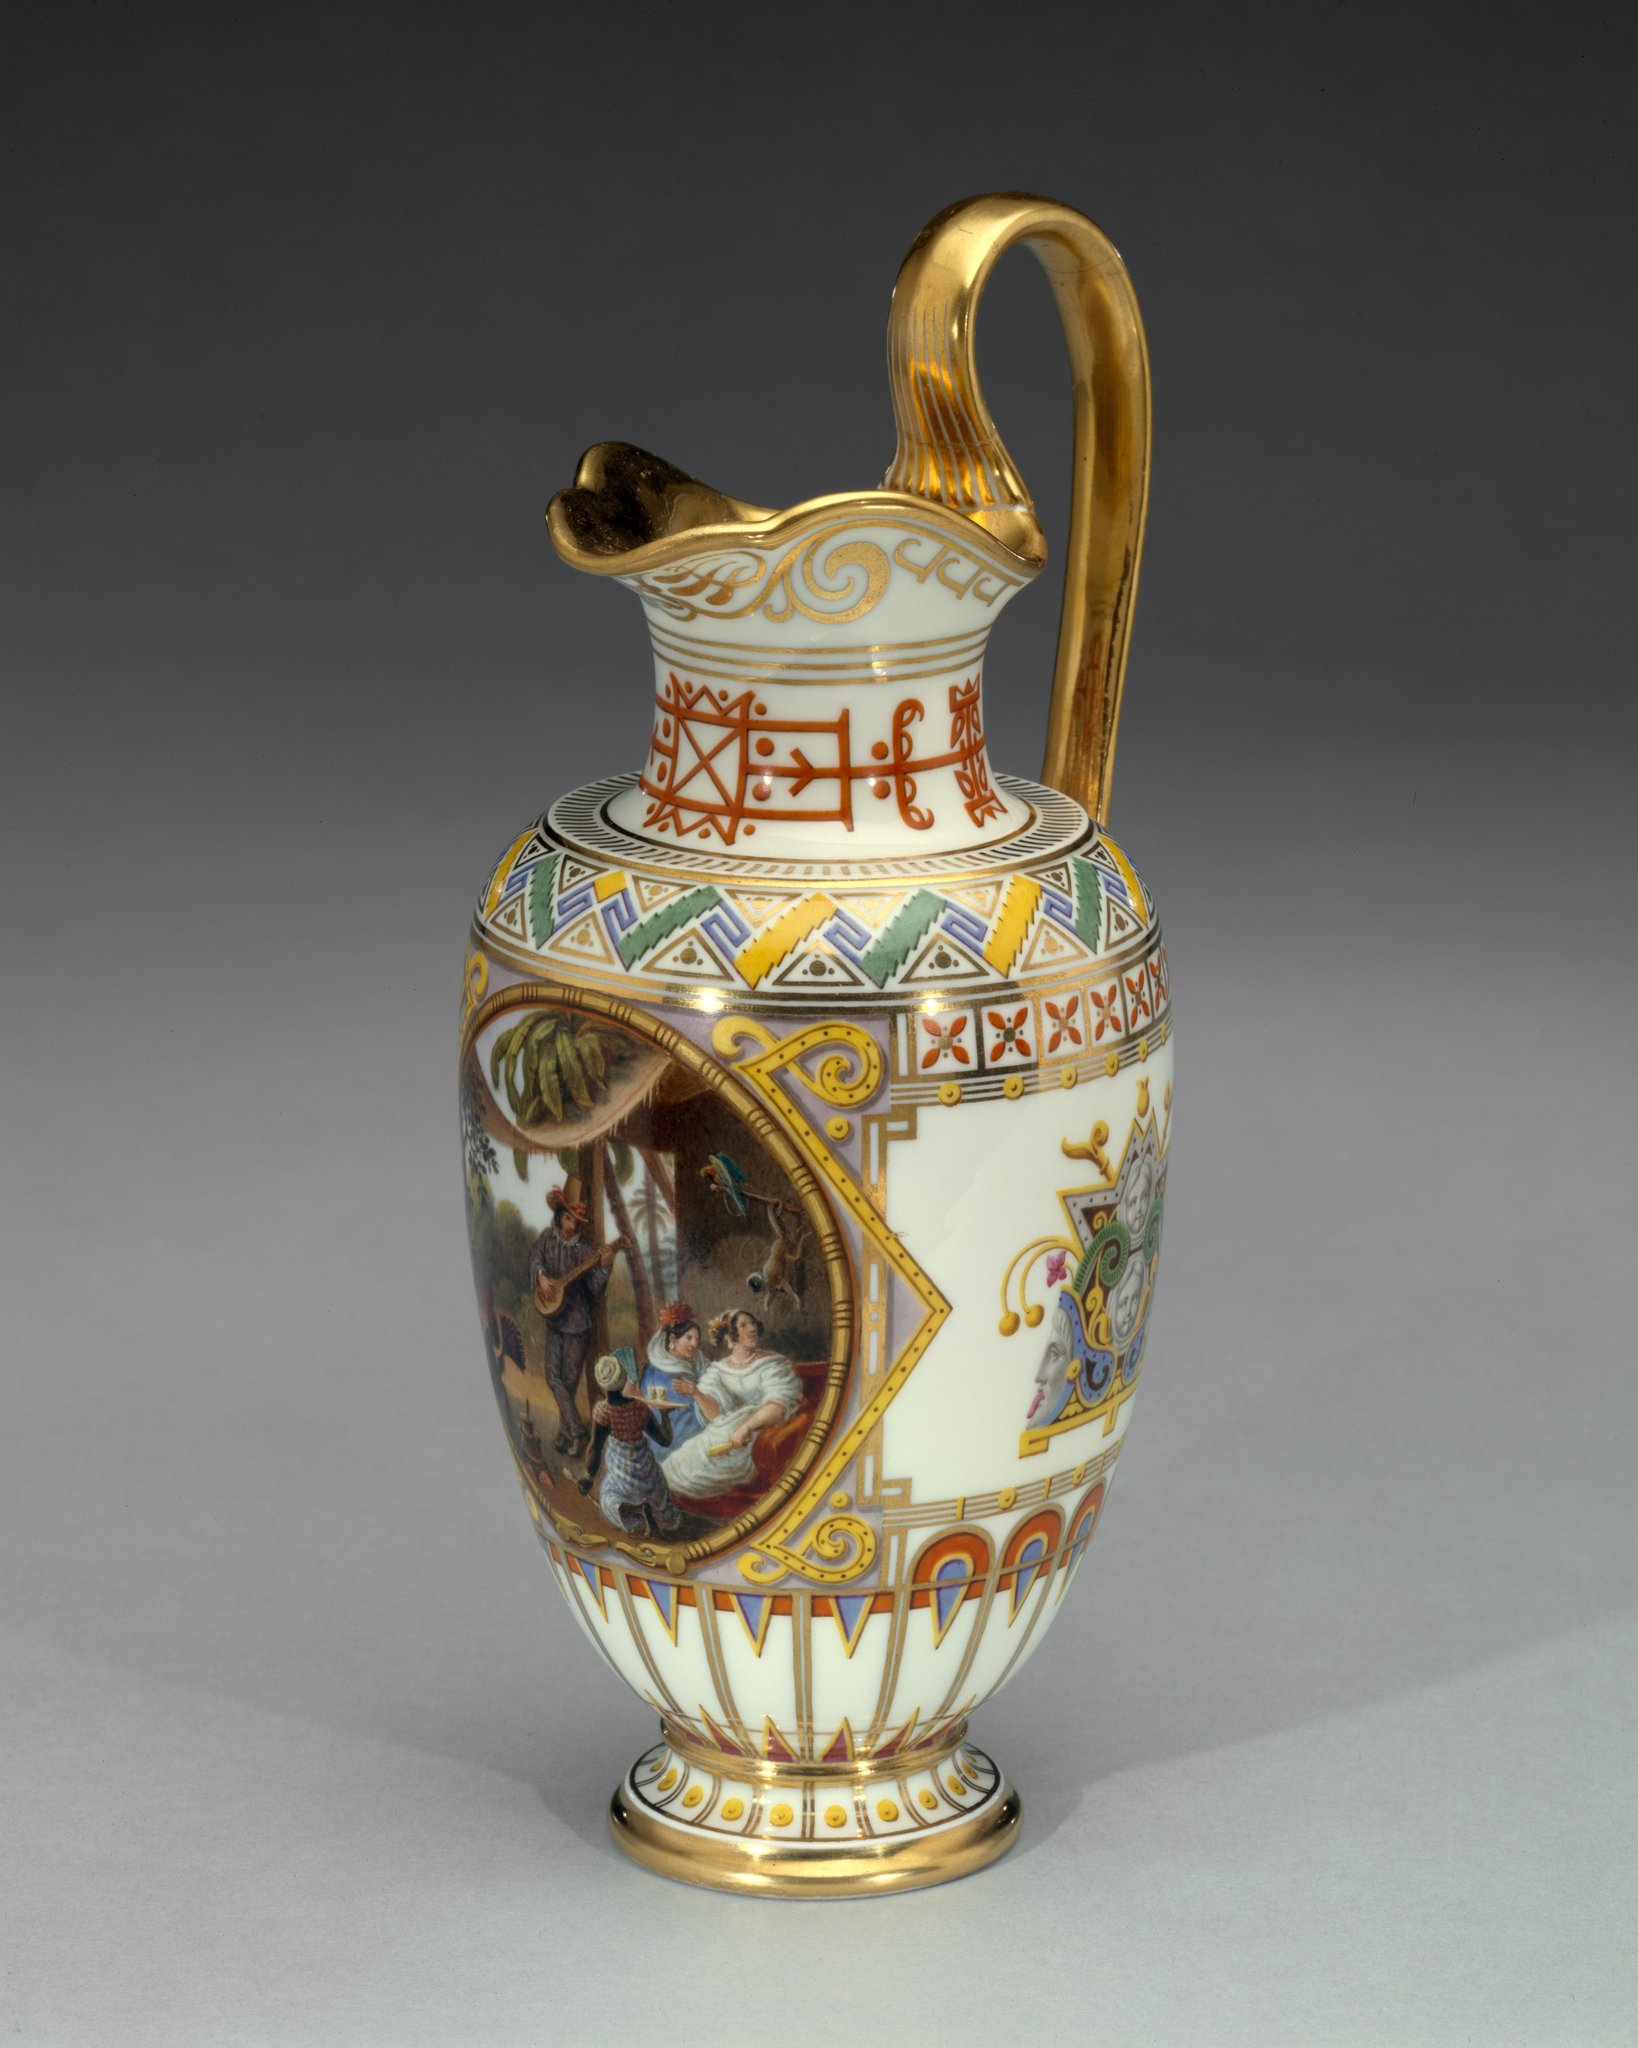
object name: milk jug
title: Milk jug (pot à lait ovoïde) (part of a service)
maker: sèvres manufactory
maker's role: manufactory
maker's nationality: french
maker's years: 1740-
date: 1836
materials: enamel, gold, hard paste porcelain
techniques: polychrome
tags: men,women,music,insignia